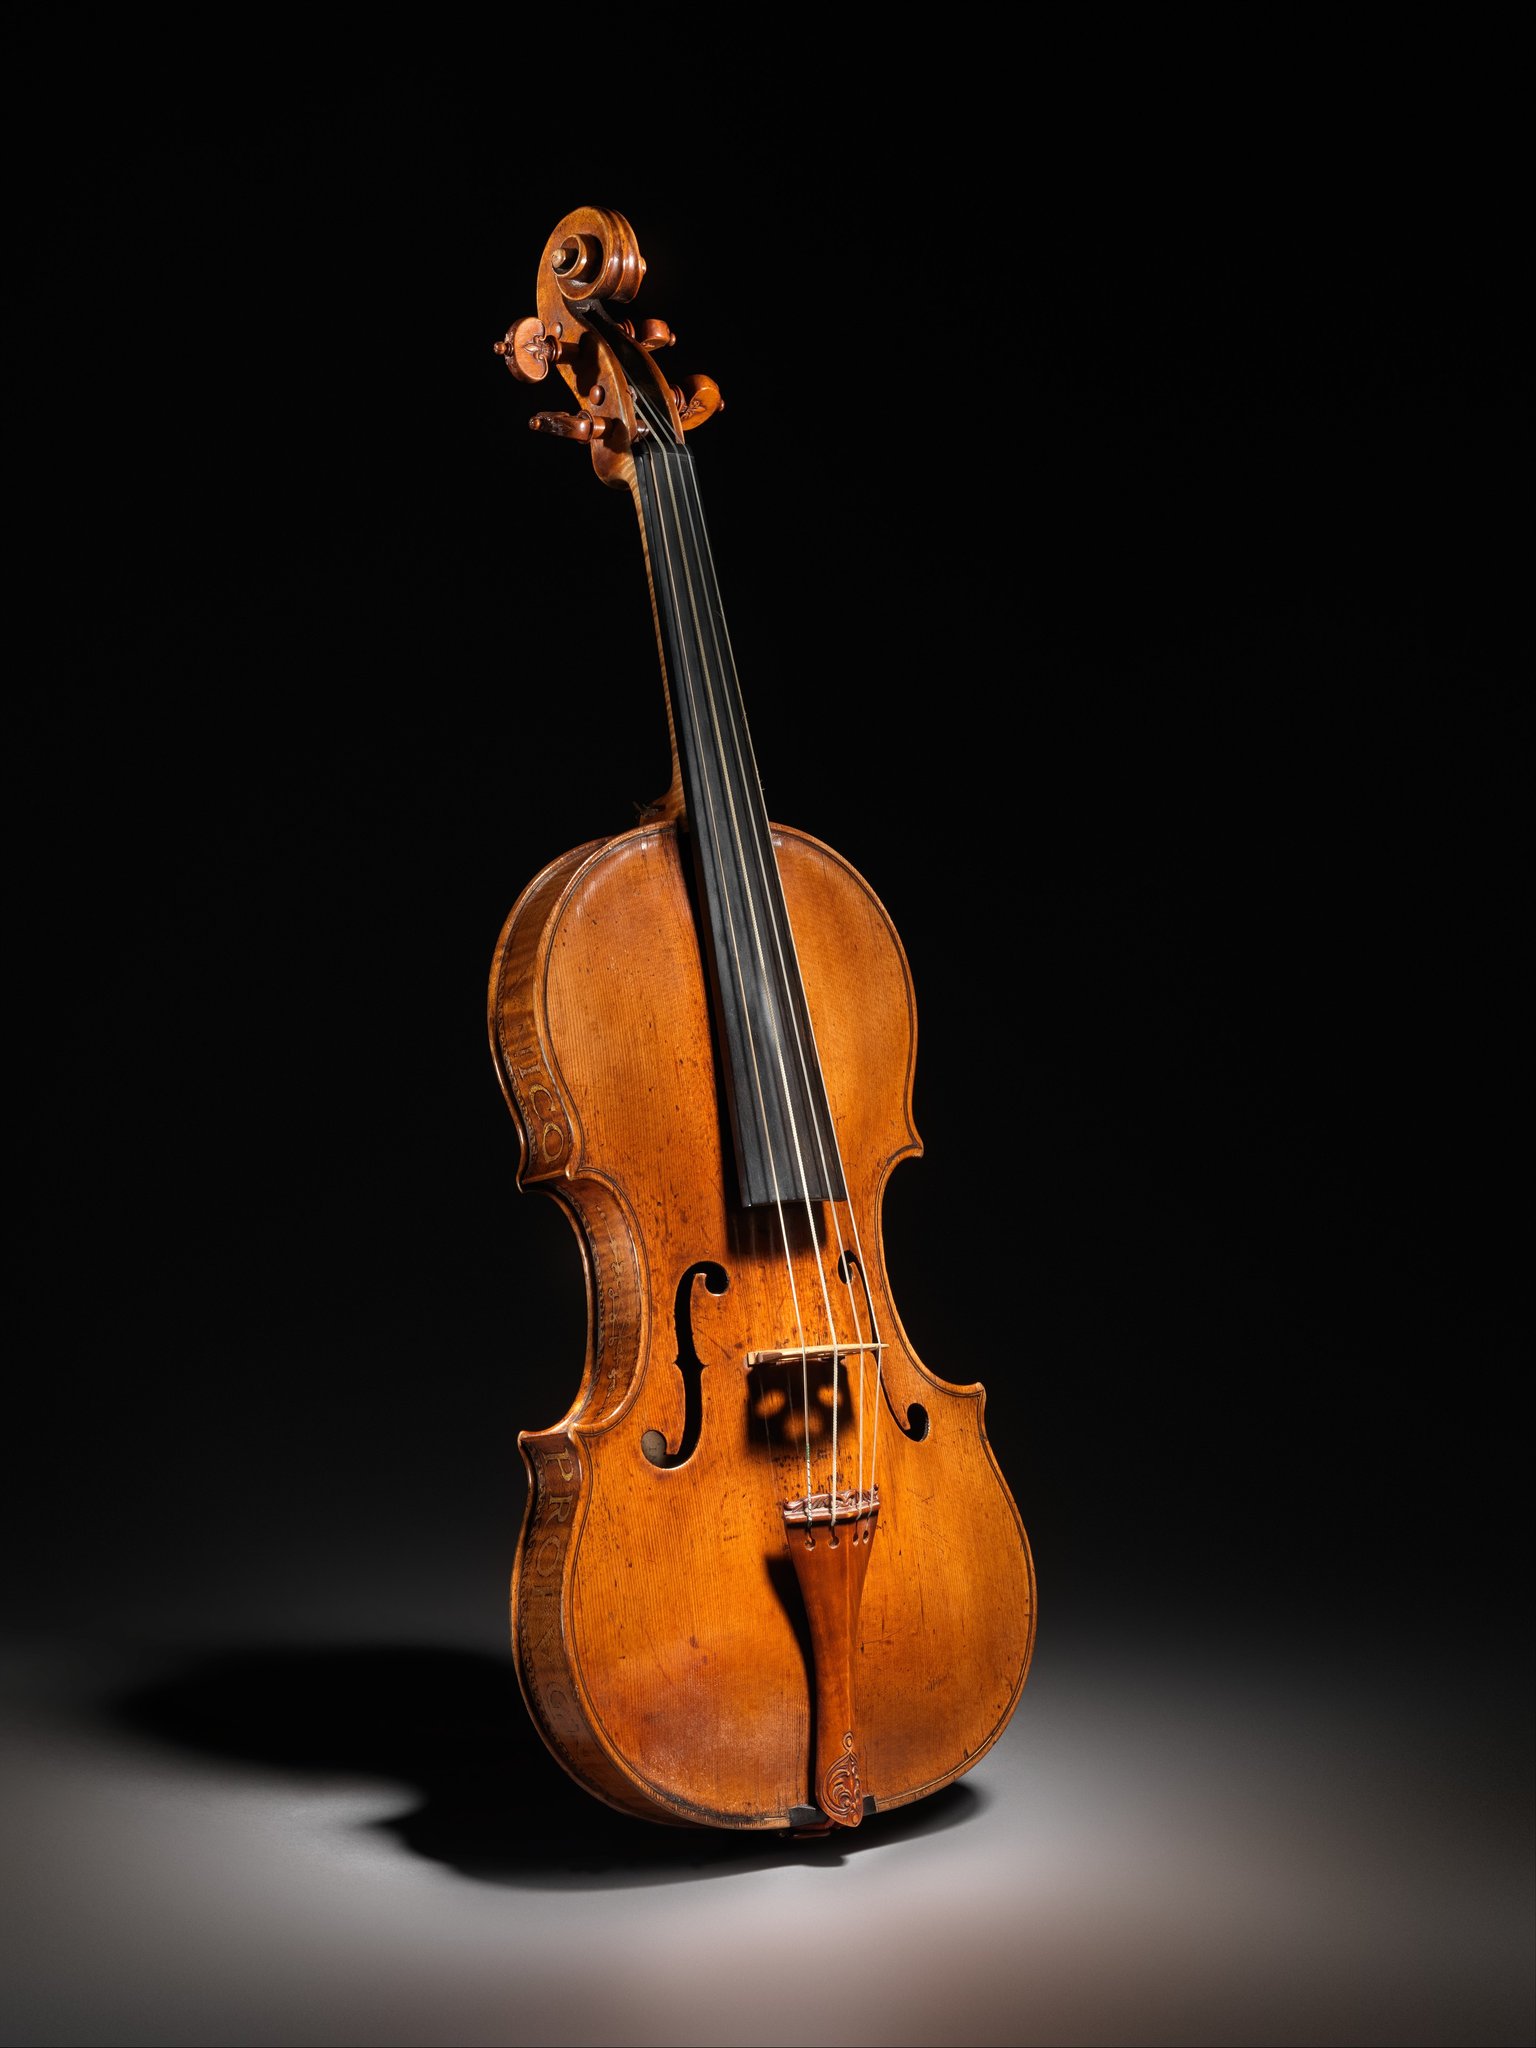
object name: violin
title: ex "Kurtz" Violin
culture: italian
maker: andrea amati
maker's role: maker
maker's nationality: italian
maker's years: 1505-1578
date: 1560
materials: wood, paint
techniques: gilding